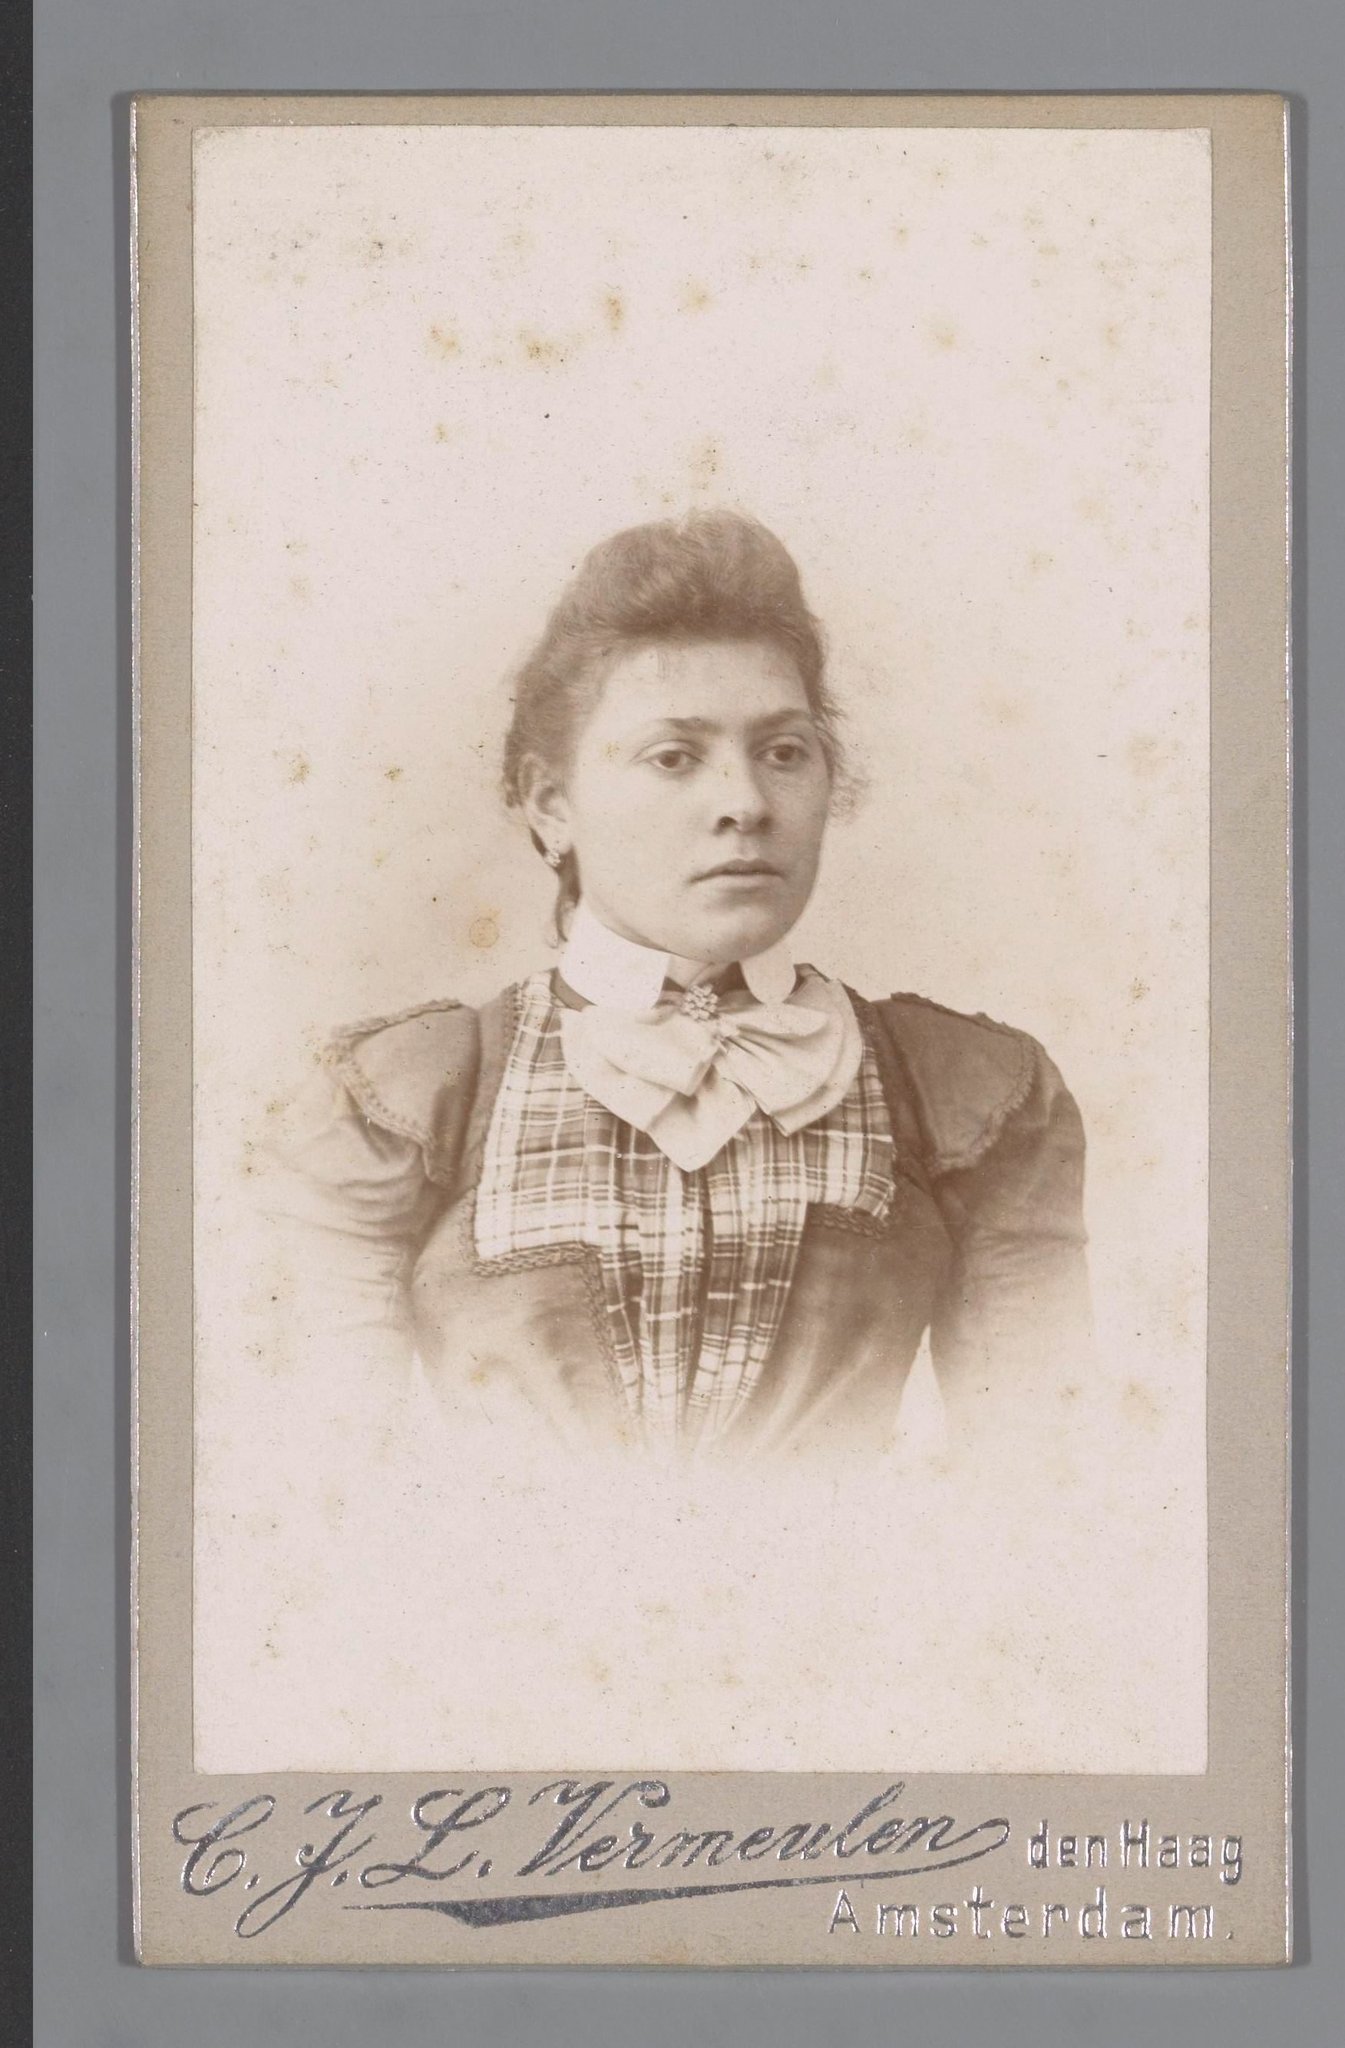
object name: photograph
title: Portret van een onbekende vrouw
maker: cornelis johannes lodewicus vermeulen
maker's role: fotograaf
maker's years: 1861-1936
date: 1890-1915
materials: cardboard, paper, photographic support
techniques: collodion silver print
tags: adult woman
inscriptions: inscription: ‘C.J.L Vermeulen Heerenstraat 6. Heiligenweg hoek Singel Telephoon No 2339 en 2340. Amsterdam. Toussaintkade 11. den Haag. Intercommunal Telephoon: 774.’, name: ‘C.J.L. Vermeulen den Haag Amsterdam.’